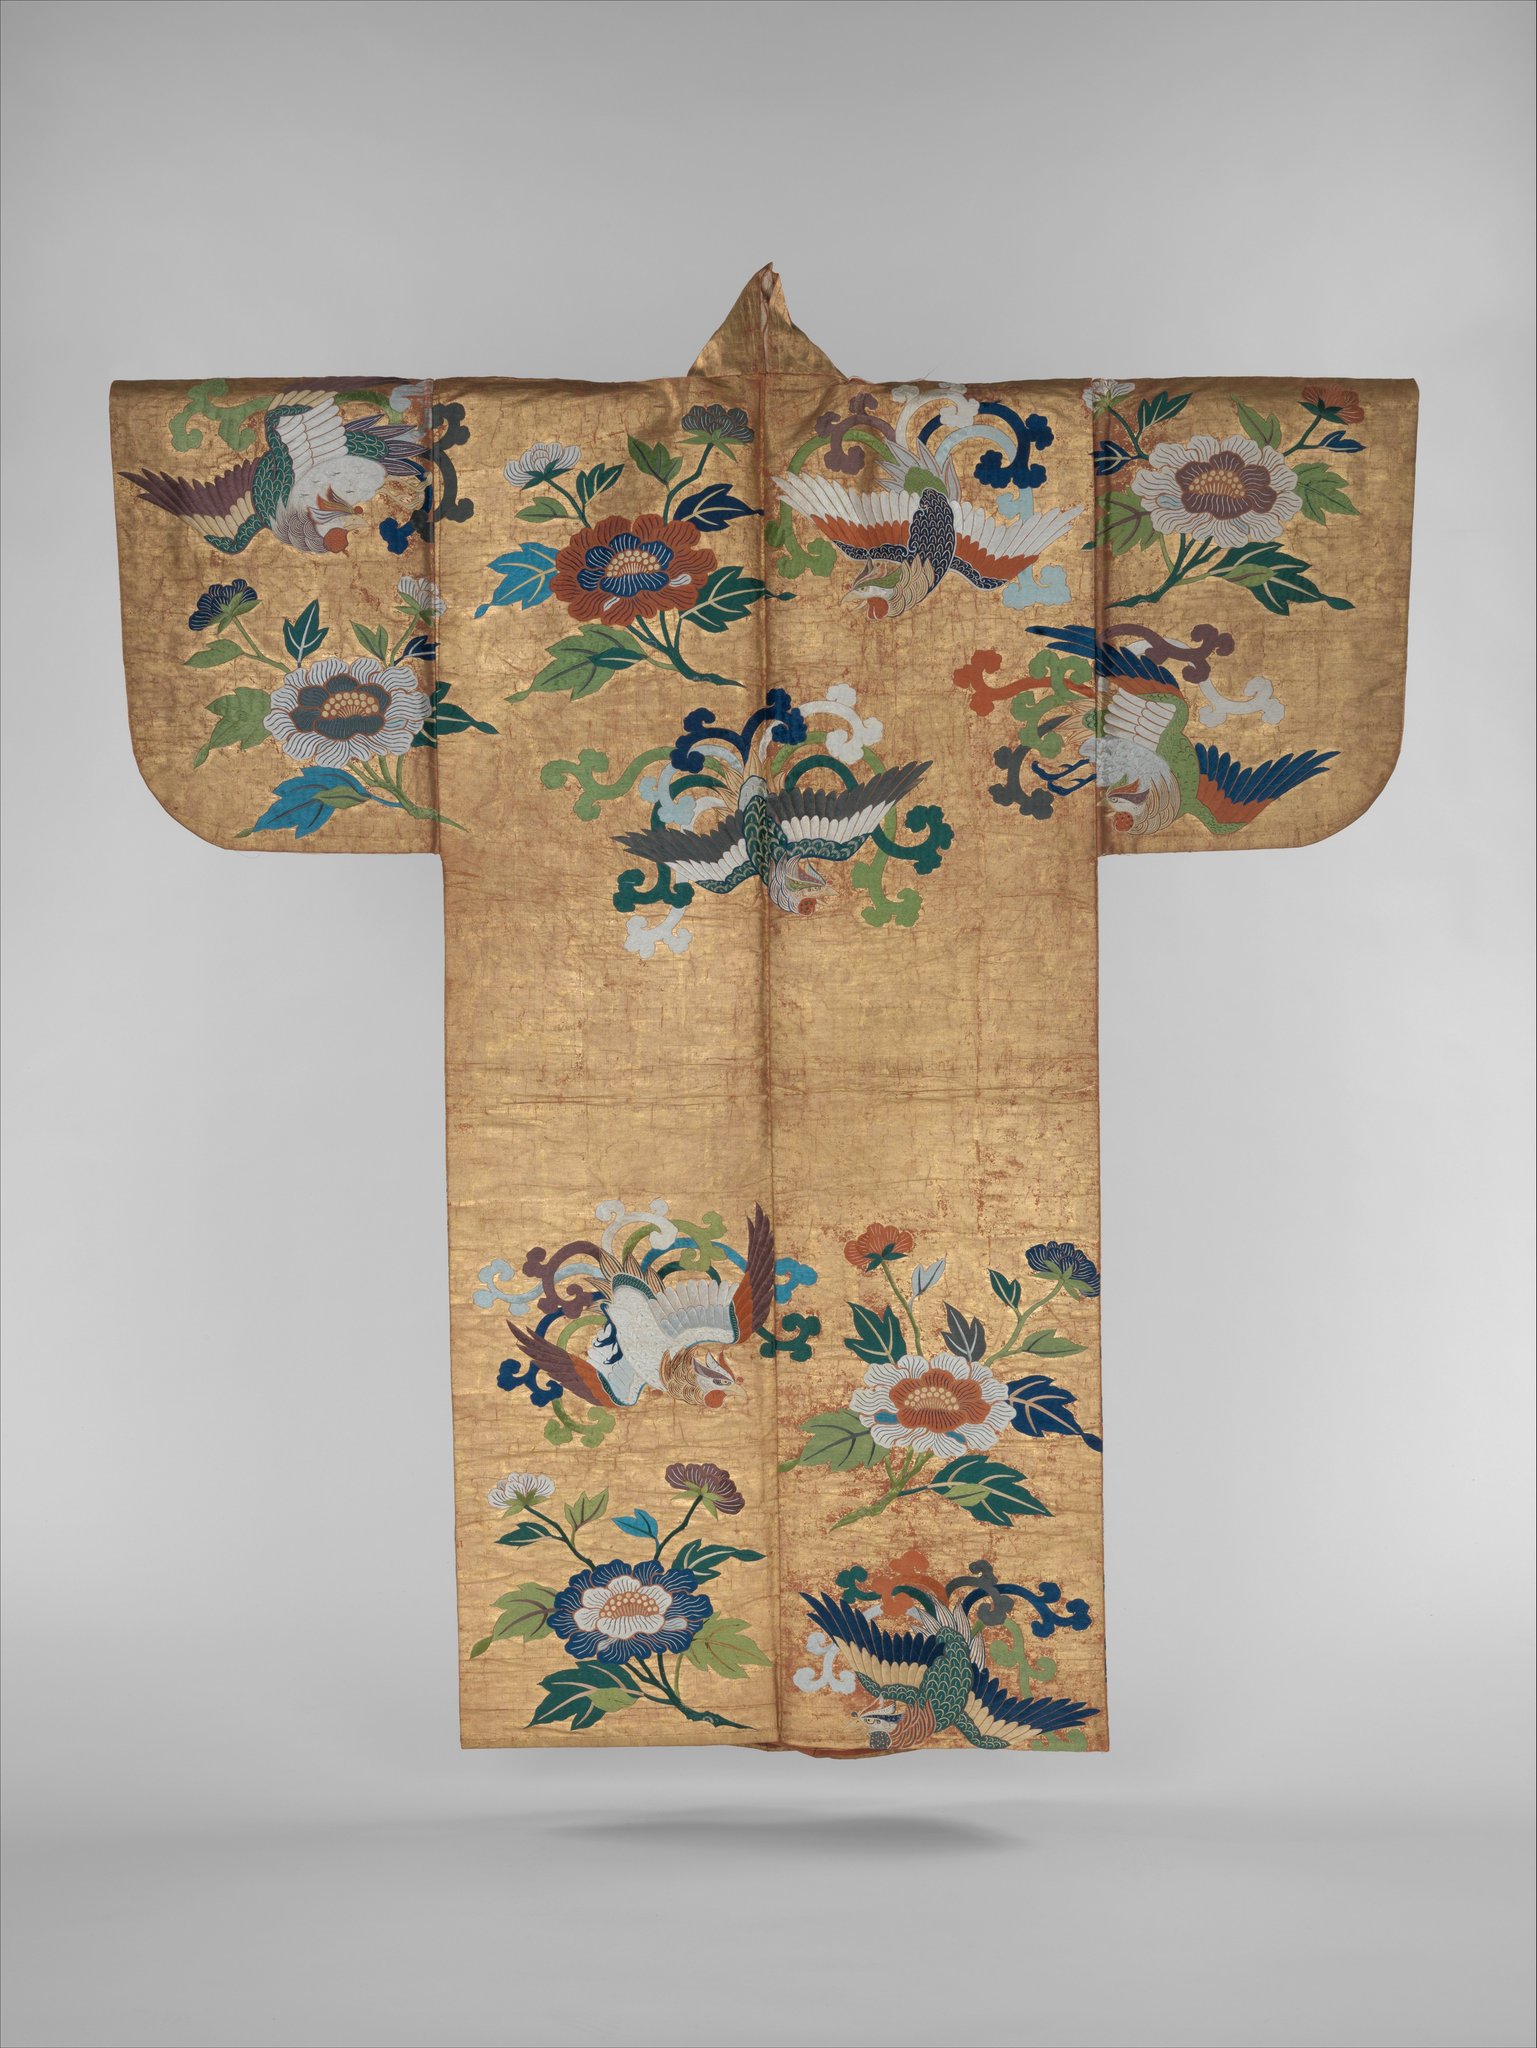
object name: noh costume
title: Noh Costume (Nuihaku) with Phoenixes and Peonies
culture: japanese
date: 1751-1800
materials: gold leaf, silk, thread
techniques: embroidery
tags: phoenix